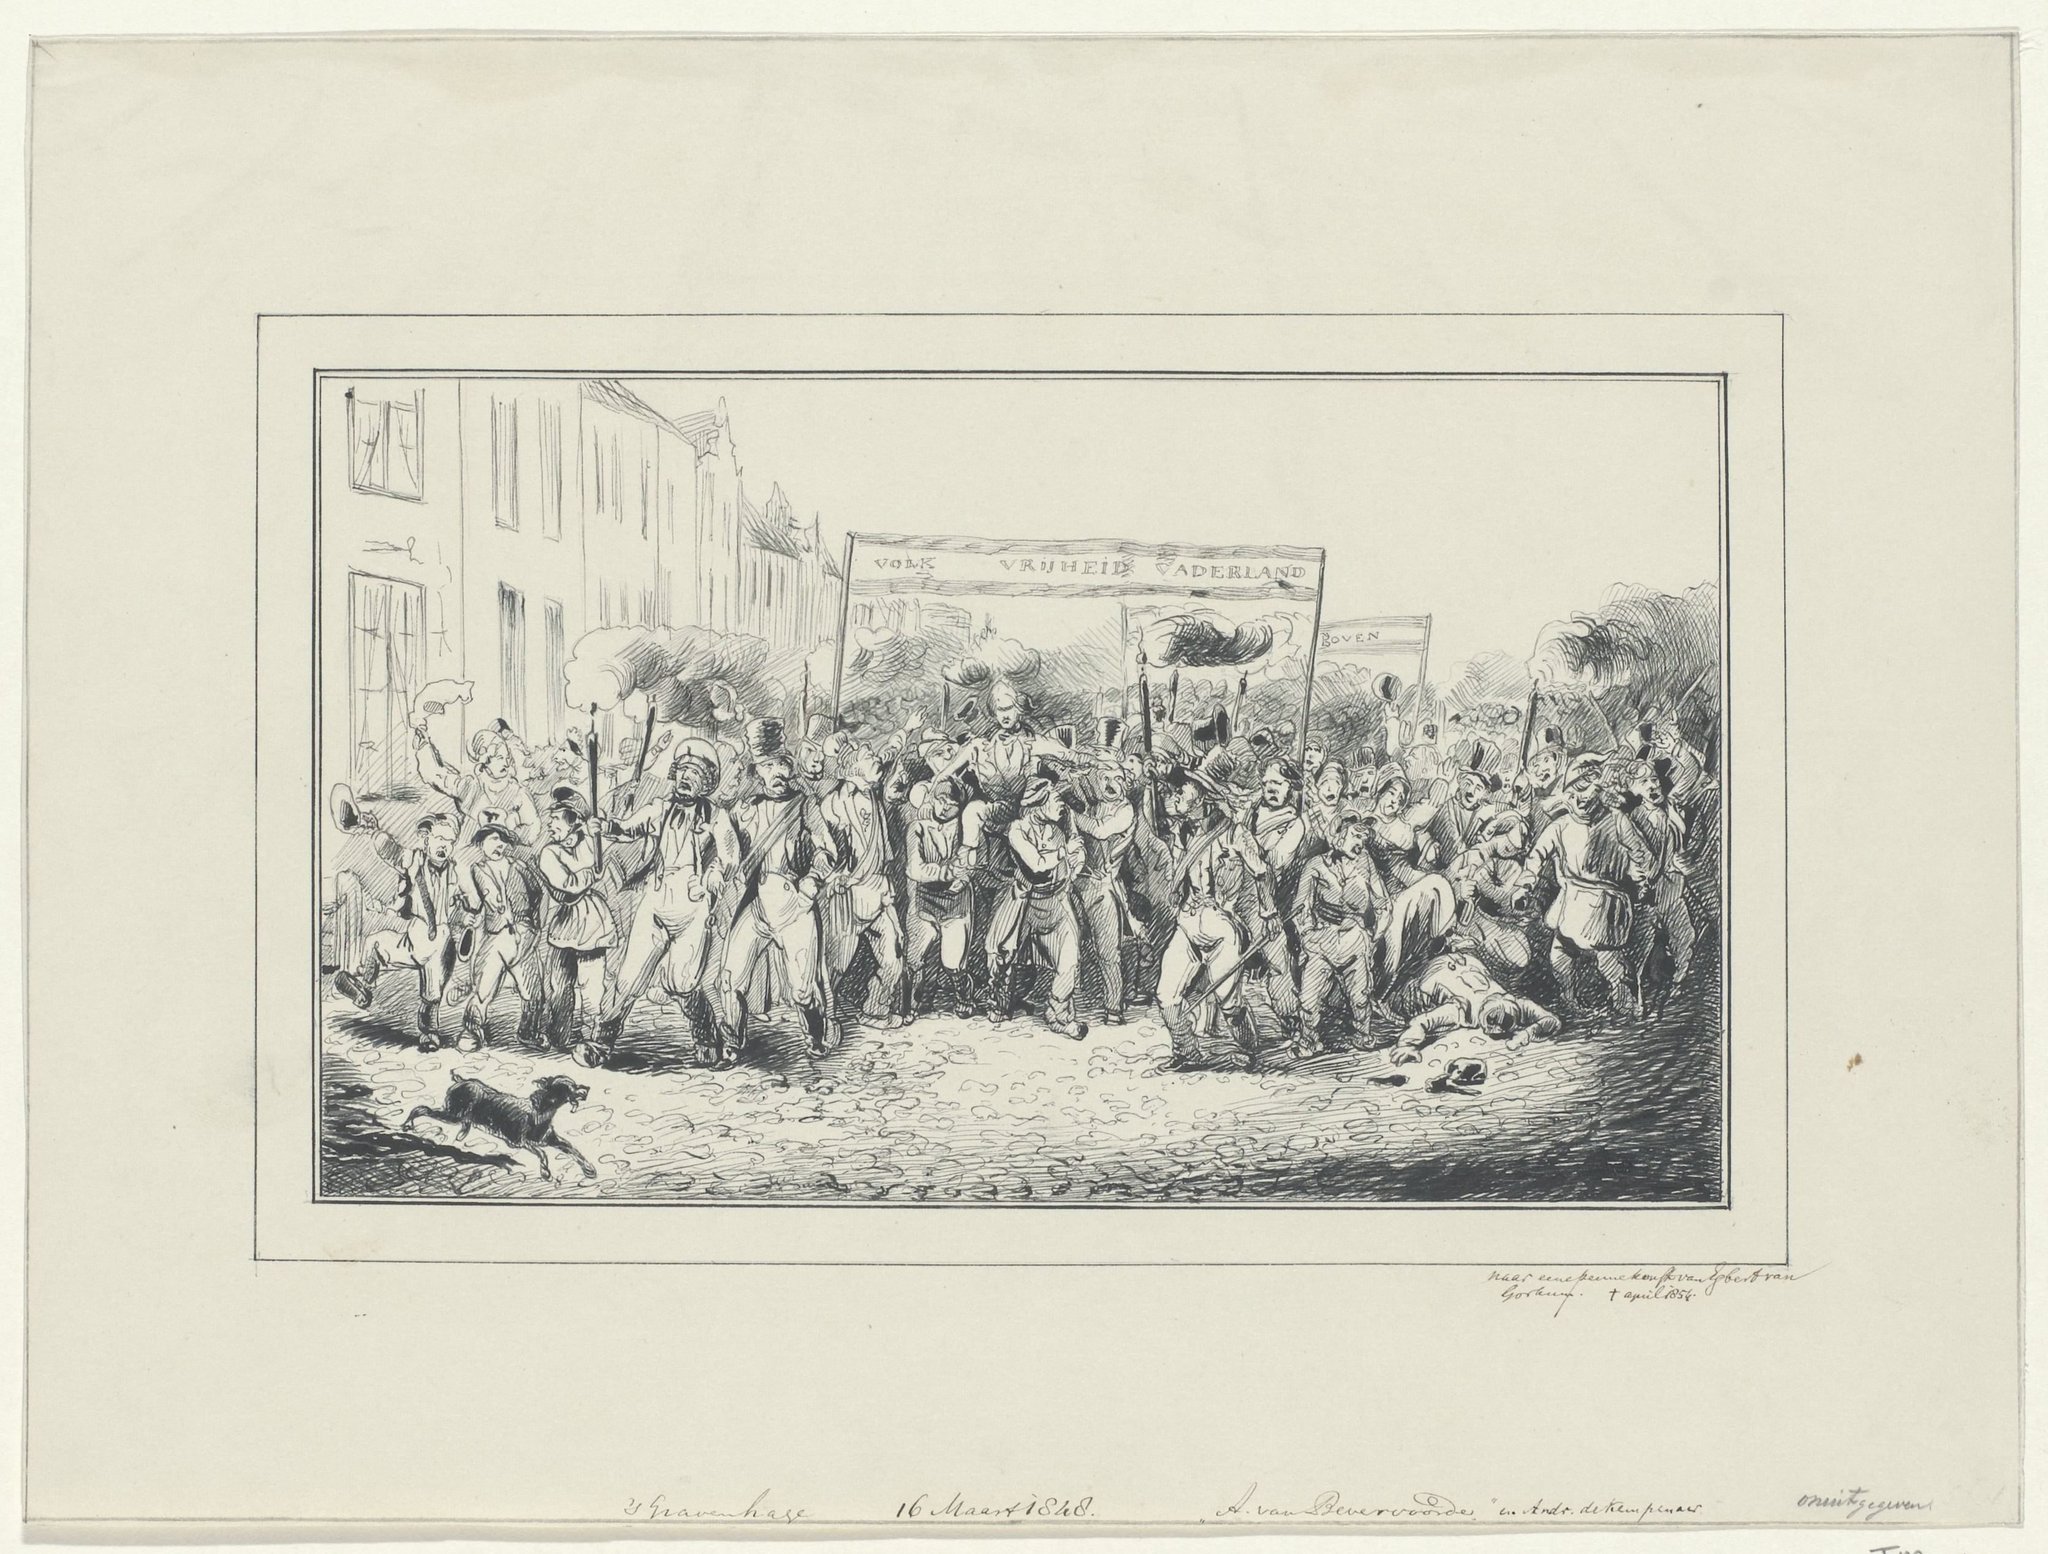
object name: drawing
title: Volksdemonstratie in Den Haag, 1848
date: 1848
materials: paper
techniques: pen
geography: netherlands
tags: political demonstration, the hague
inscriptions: collector's mark: Lugt 2228, inscription: ‘naar eene pennekonst van Egbert van Gorkum. t april 1854 / 's Gravenhage 16 Maart 1848. "A. van Bevervoorde" en Andr. de Kempenaar / onuitgegeven’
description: Volksdemonstratie in Den Haag, 16 maart 1848. Een menigte met spandoek 'Volk Vrijheid Vaderland' en brandende toortsen loopt door een straat. Op de voorste rij wordt een man, A. van Bevervoorde, redacteur van het weekblad 'De Burger', op de schouders gedragen.